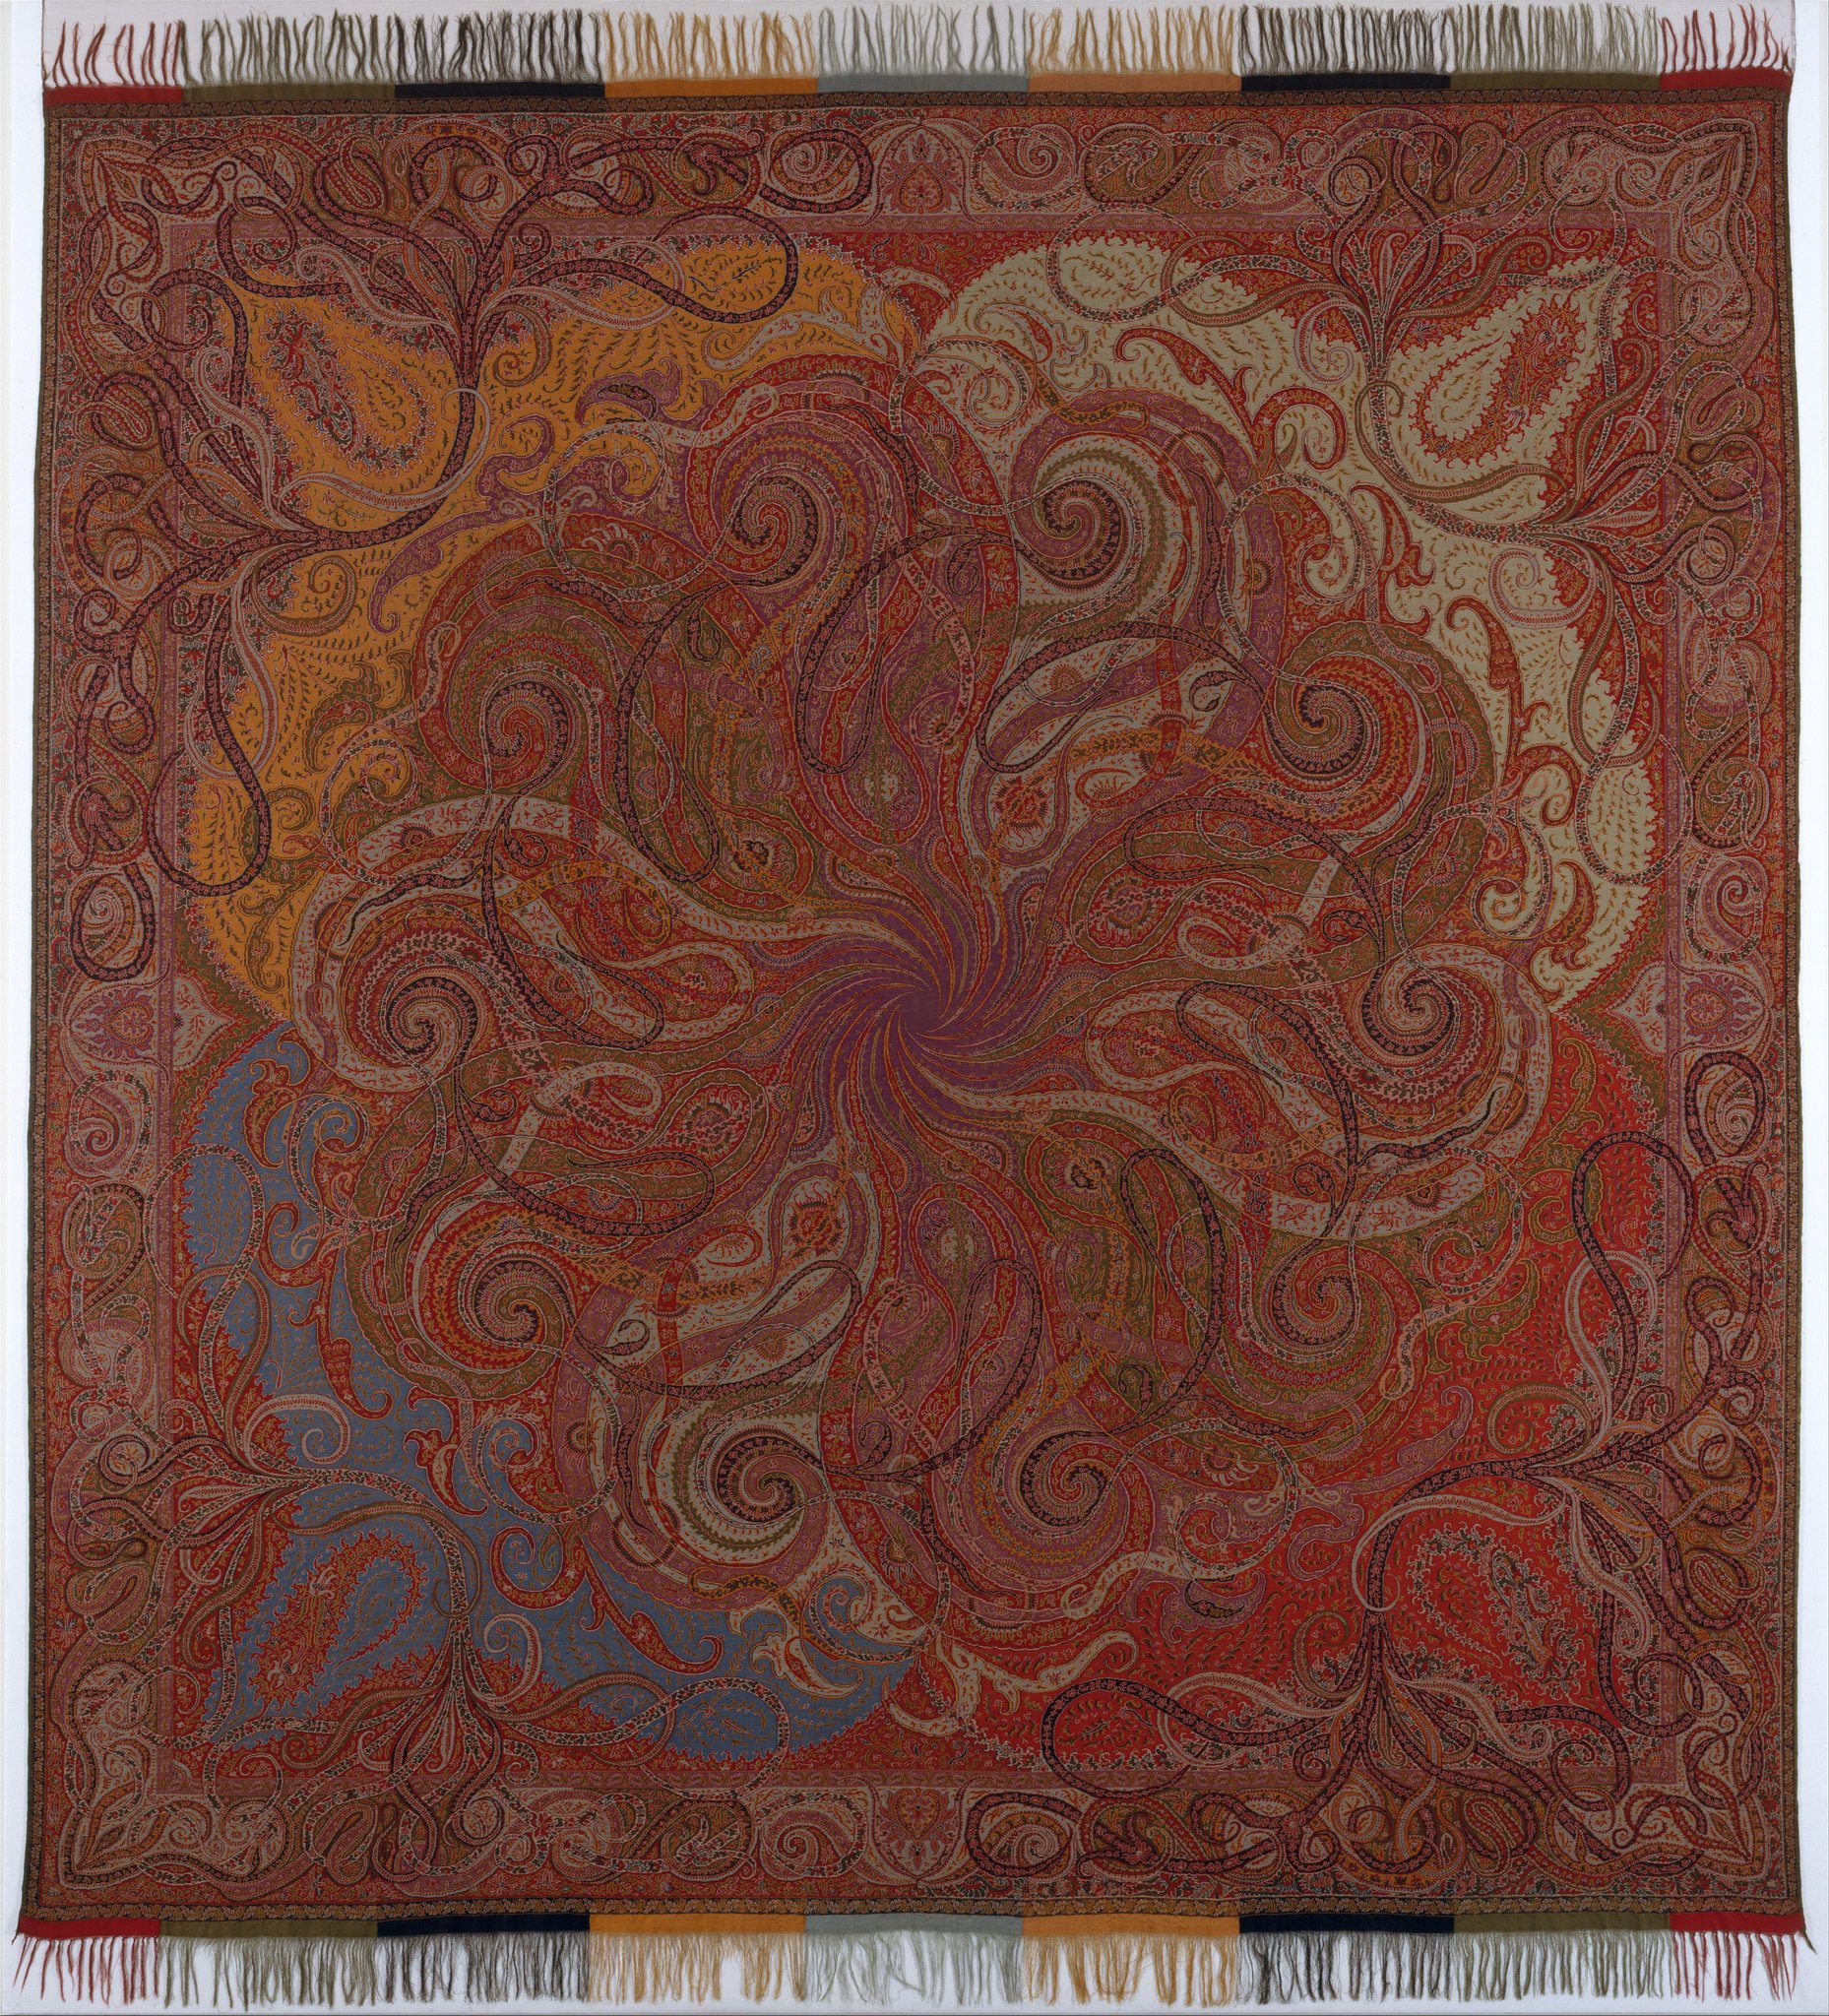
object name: shawl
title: Four Seasons shawl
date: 1834-1866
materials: silk, wool